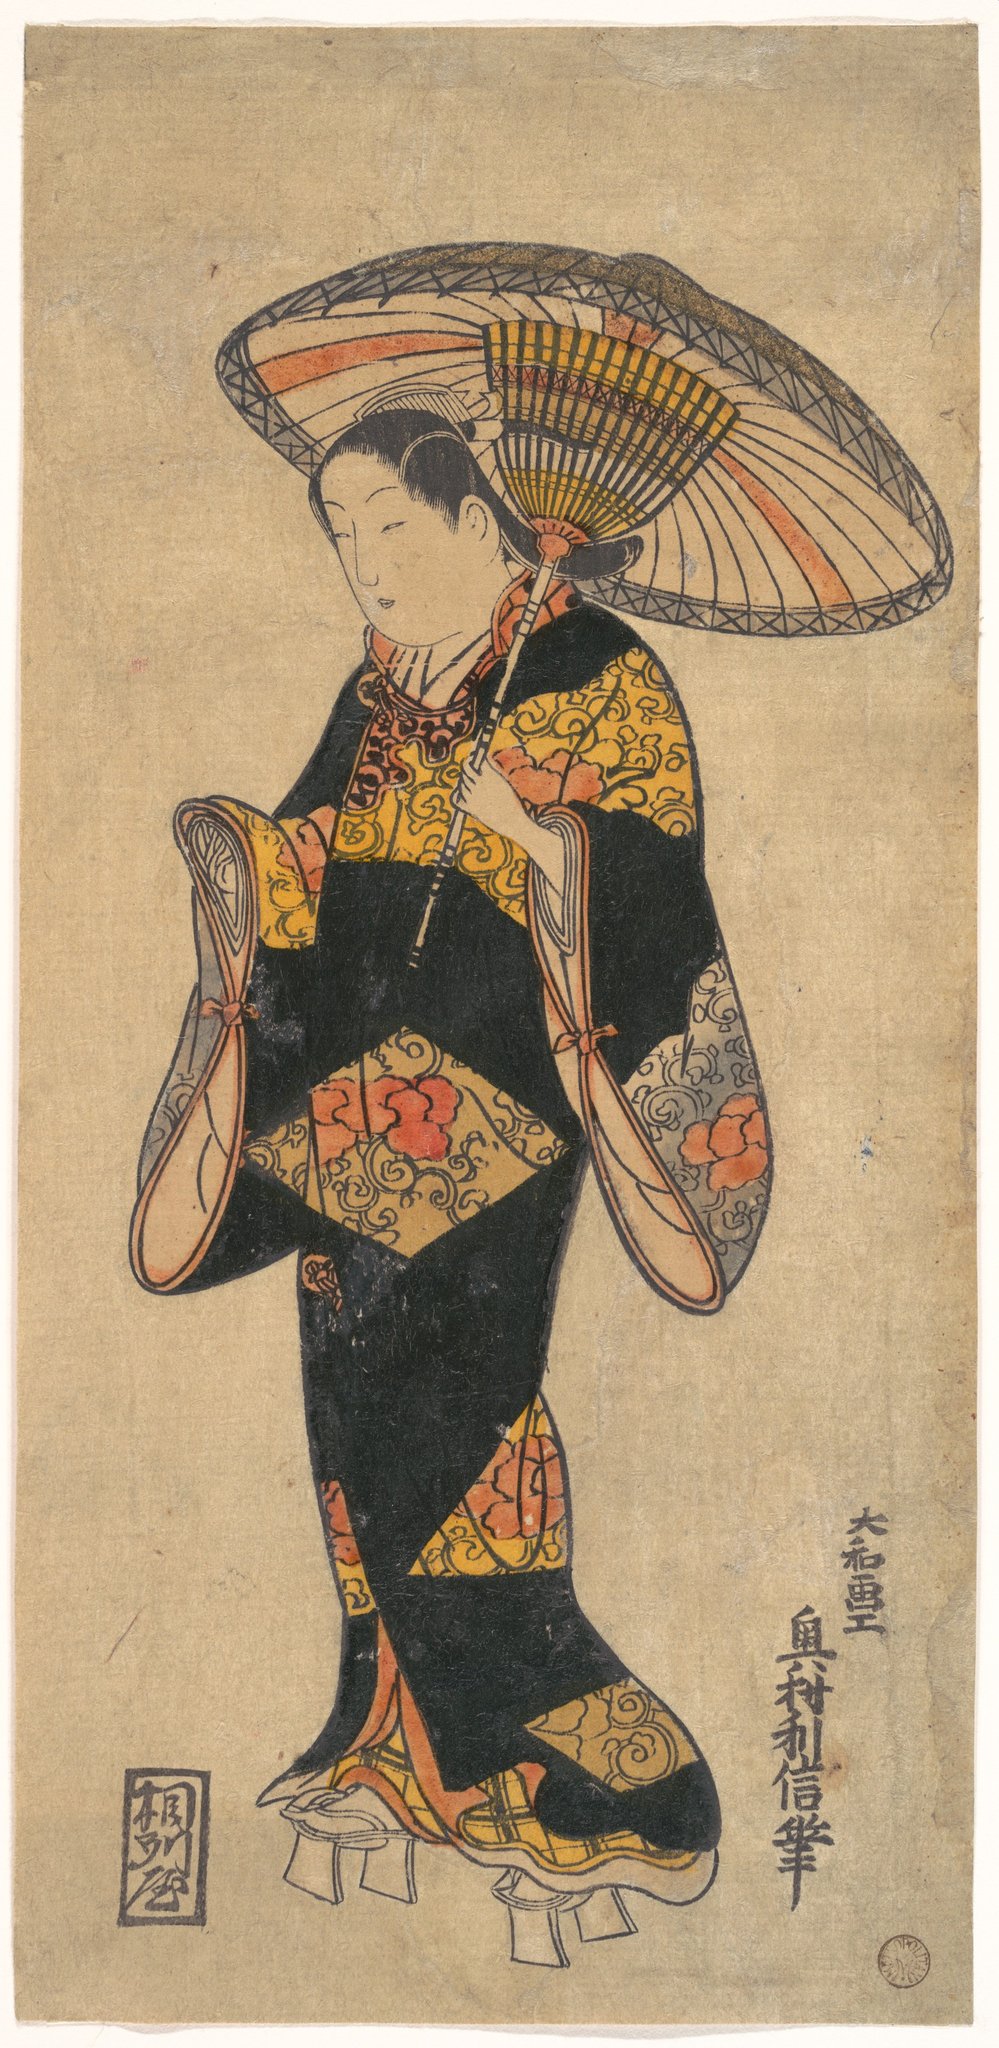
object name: print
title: Actor (Sanjo Kantaro?) in the Role of a Courtesan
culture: japanese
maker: okumura toshinobu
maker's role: artist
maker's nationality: japanese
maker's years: 1717-1750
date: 1728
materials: ink, paper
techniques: urushi, woodblock print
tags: women,actors,umbrellas